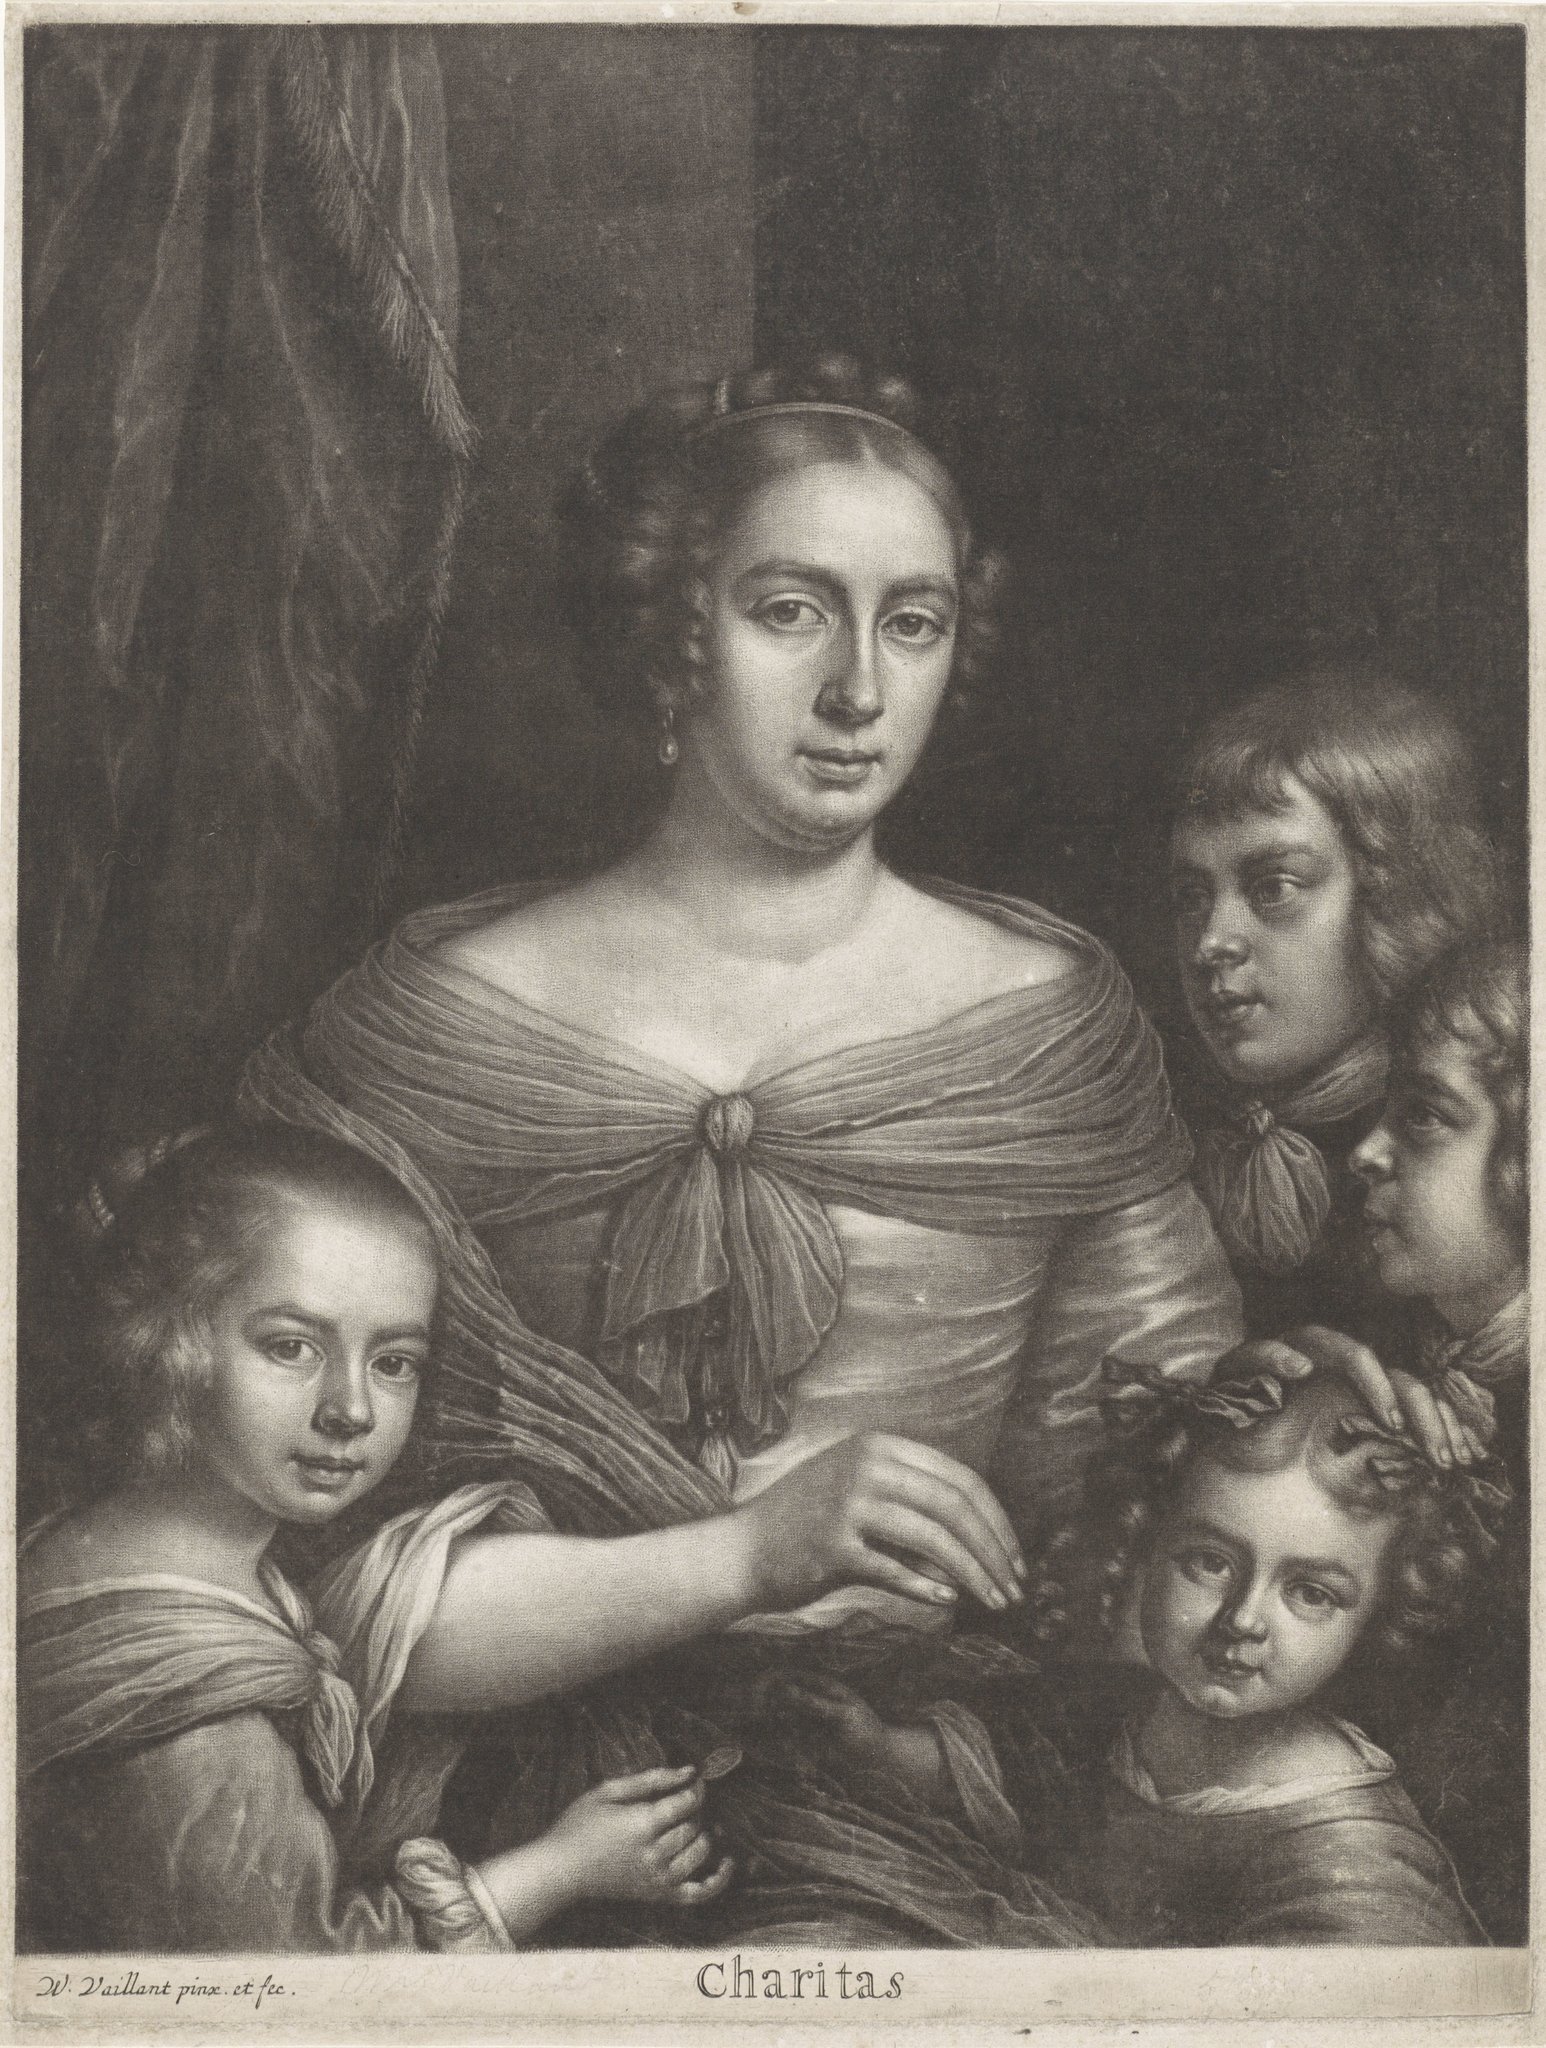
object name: print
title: Portret van een moeder met vier kinderen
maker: wallerant vaillant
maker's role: draughtsman, painter, print maker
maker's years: 1623-1677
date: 1658-1677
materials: paper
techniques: mezzotint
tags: charity, 'caritas'; 'carità' (ripa) ~ one of the three theological virtues, mother and baby or young child, mother and child(ren), woman and child(ren) (family group), necklace (+ women's clothes)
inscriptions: collector's mark: Lugt 2036, collector's mark: Lugt 2228